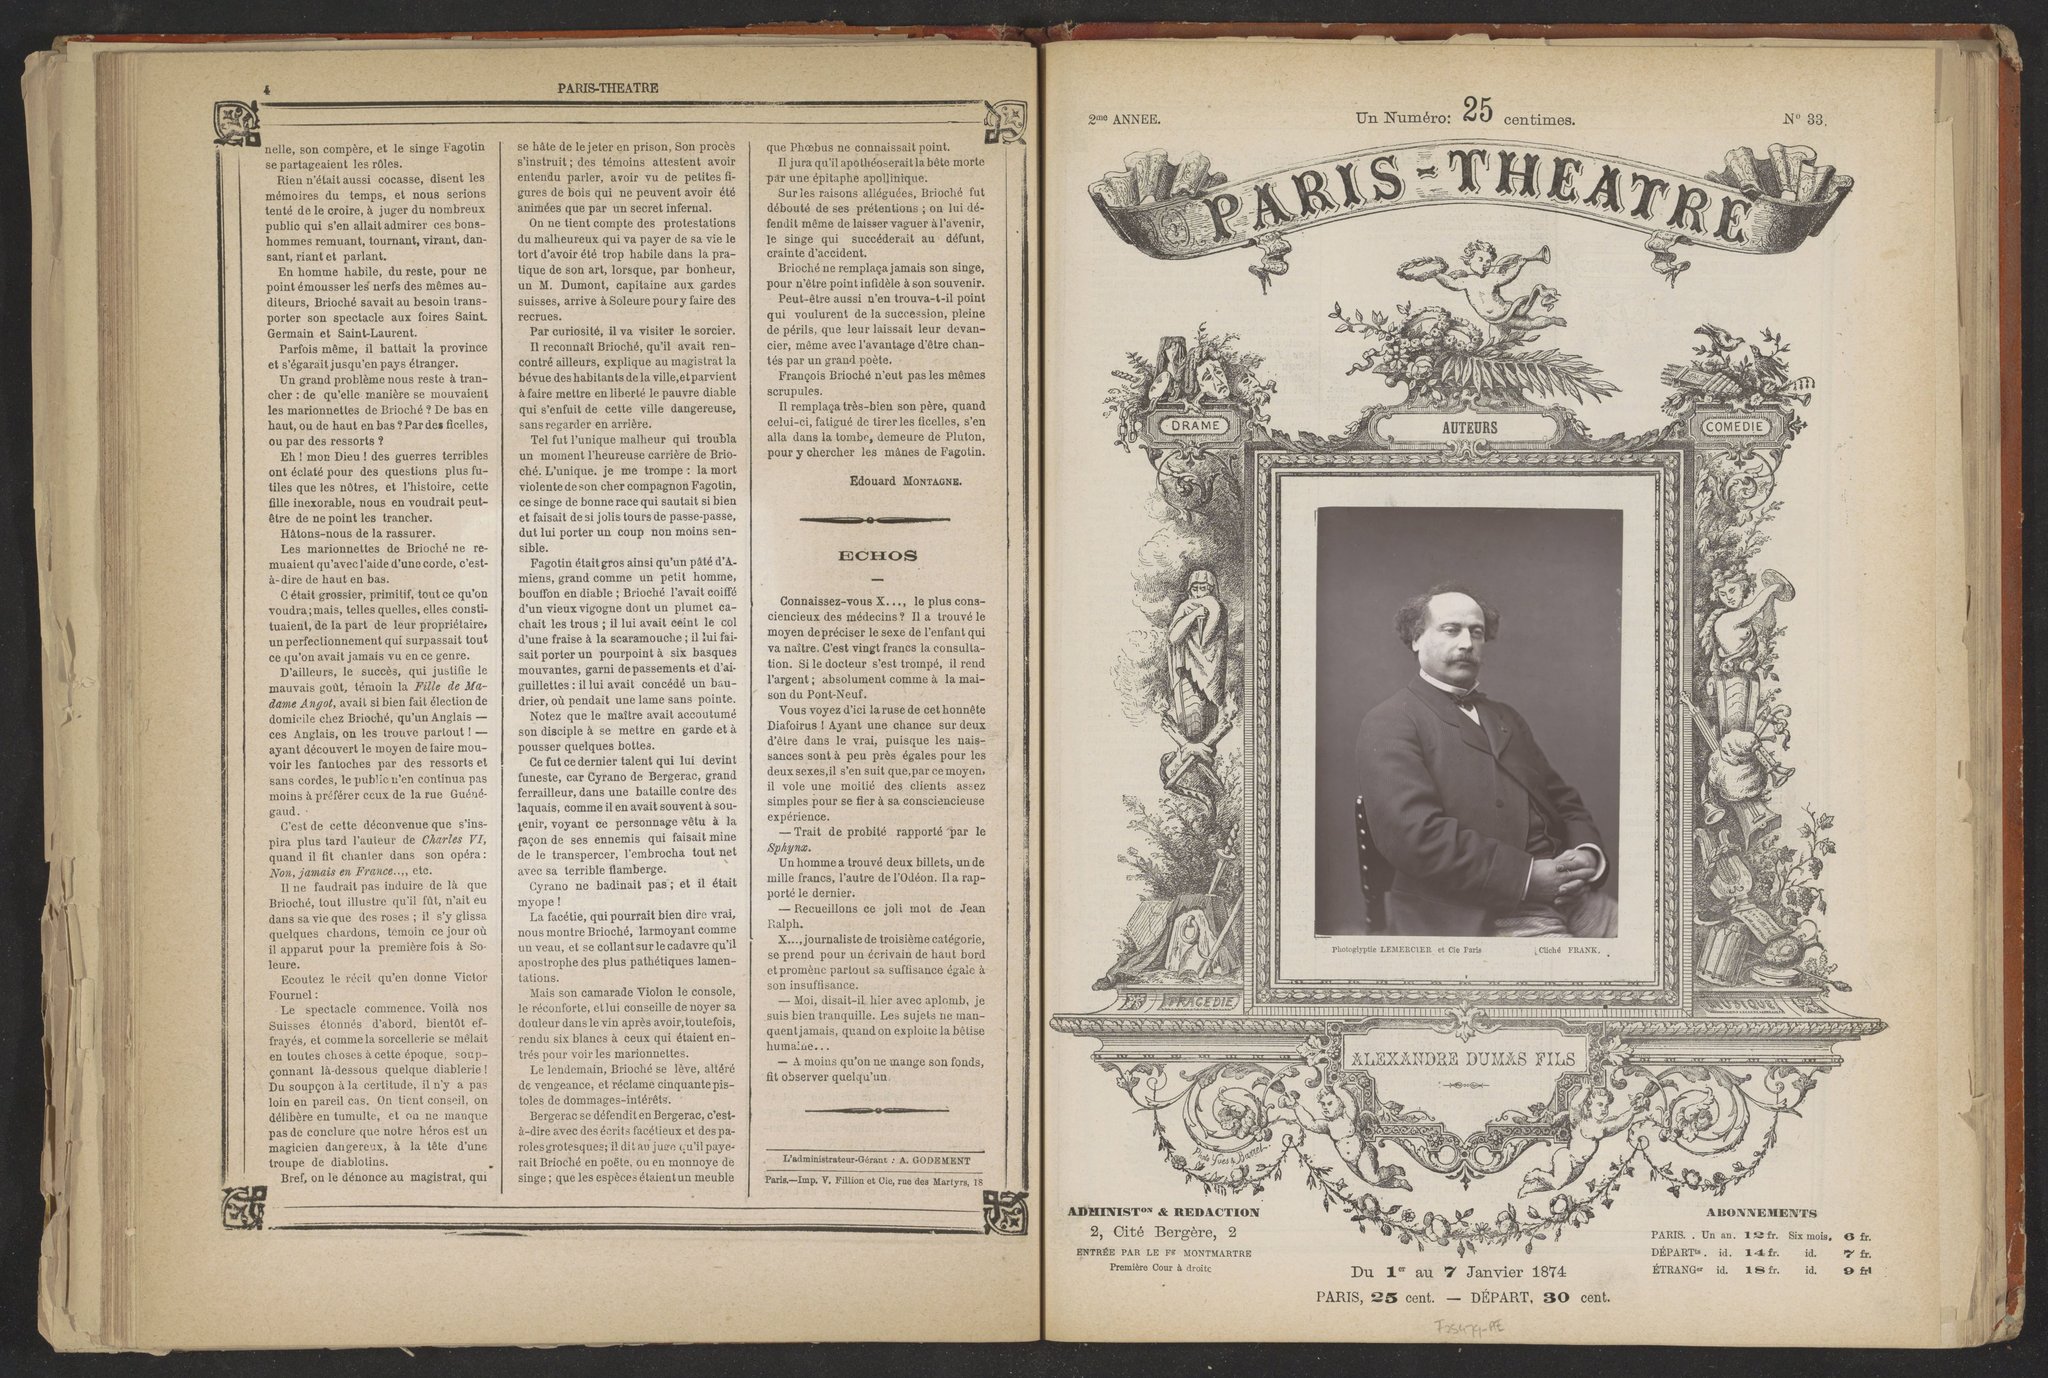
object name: photomechanical print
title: Alexandre Dumas Fils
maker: frank (fotograaf)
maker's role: fotograaf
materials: paper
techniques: woodburytype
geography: france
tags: paris, portrait of artiste (dancer, actor, etc.)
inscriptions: number: ‘No 33.’, inscription: ‘Du 1er au 7 Janvier 1874’